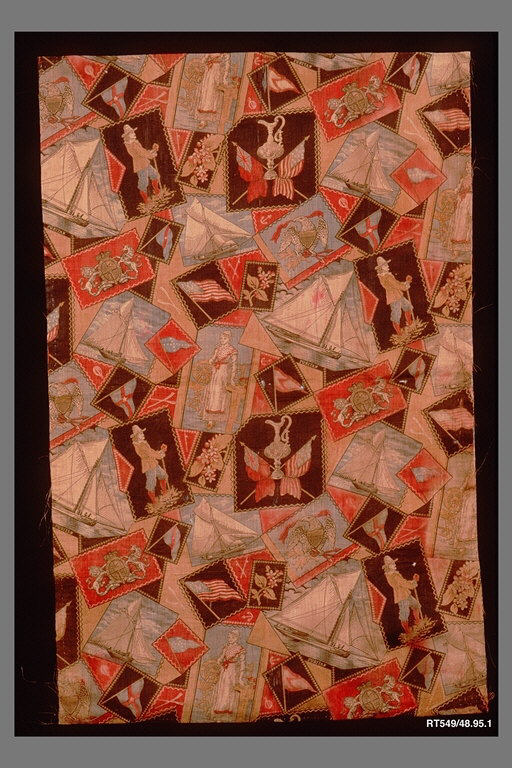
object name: piece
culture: american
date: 1886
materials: cotton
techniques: printing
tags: men,women,flags,ships